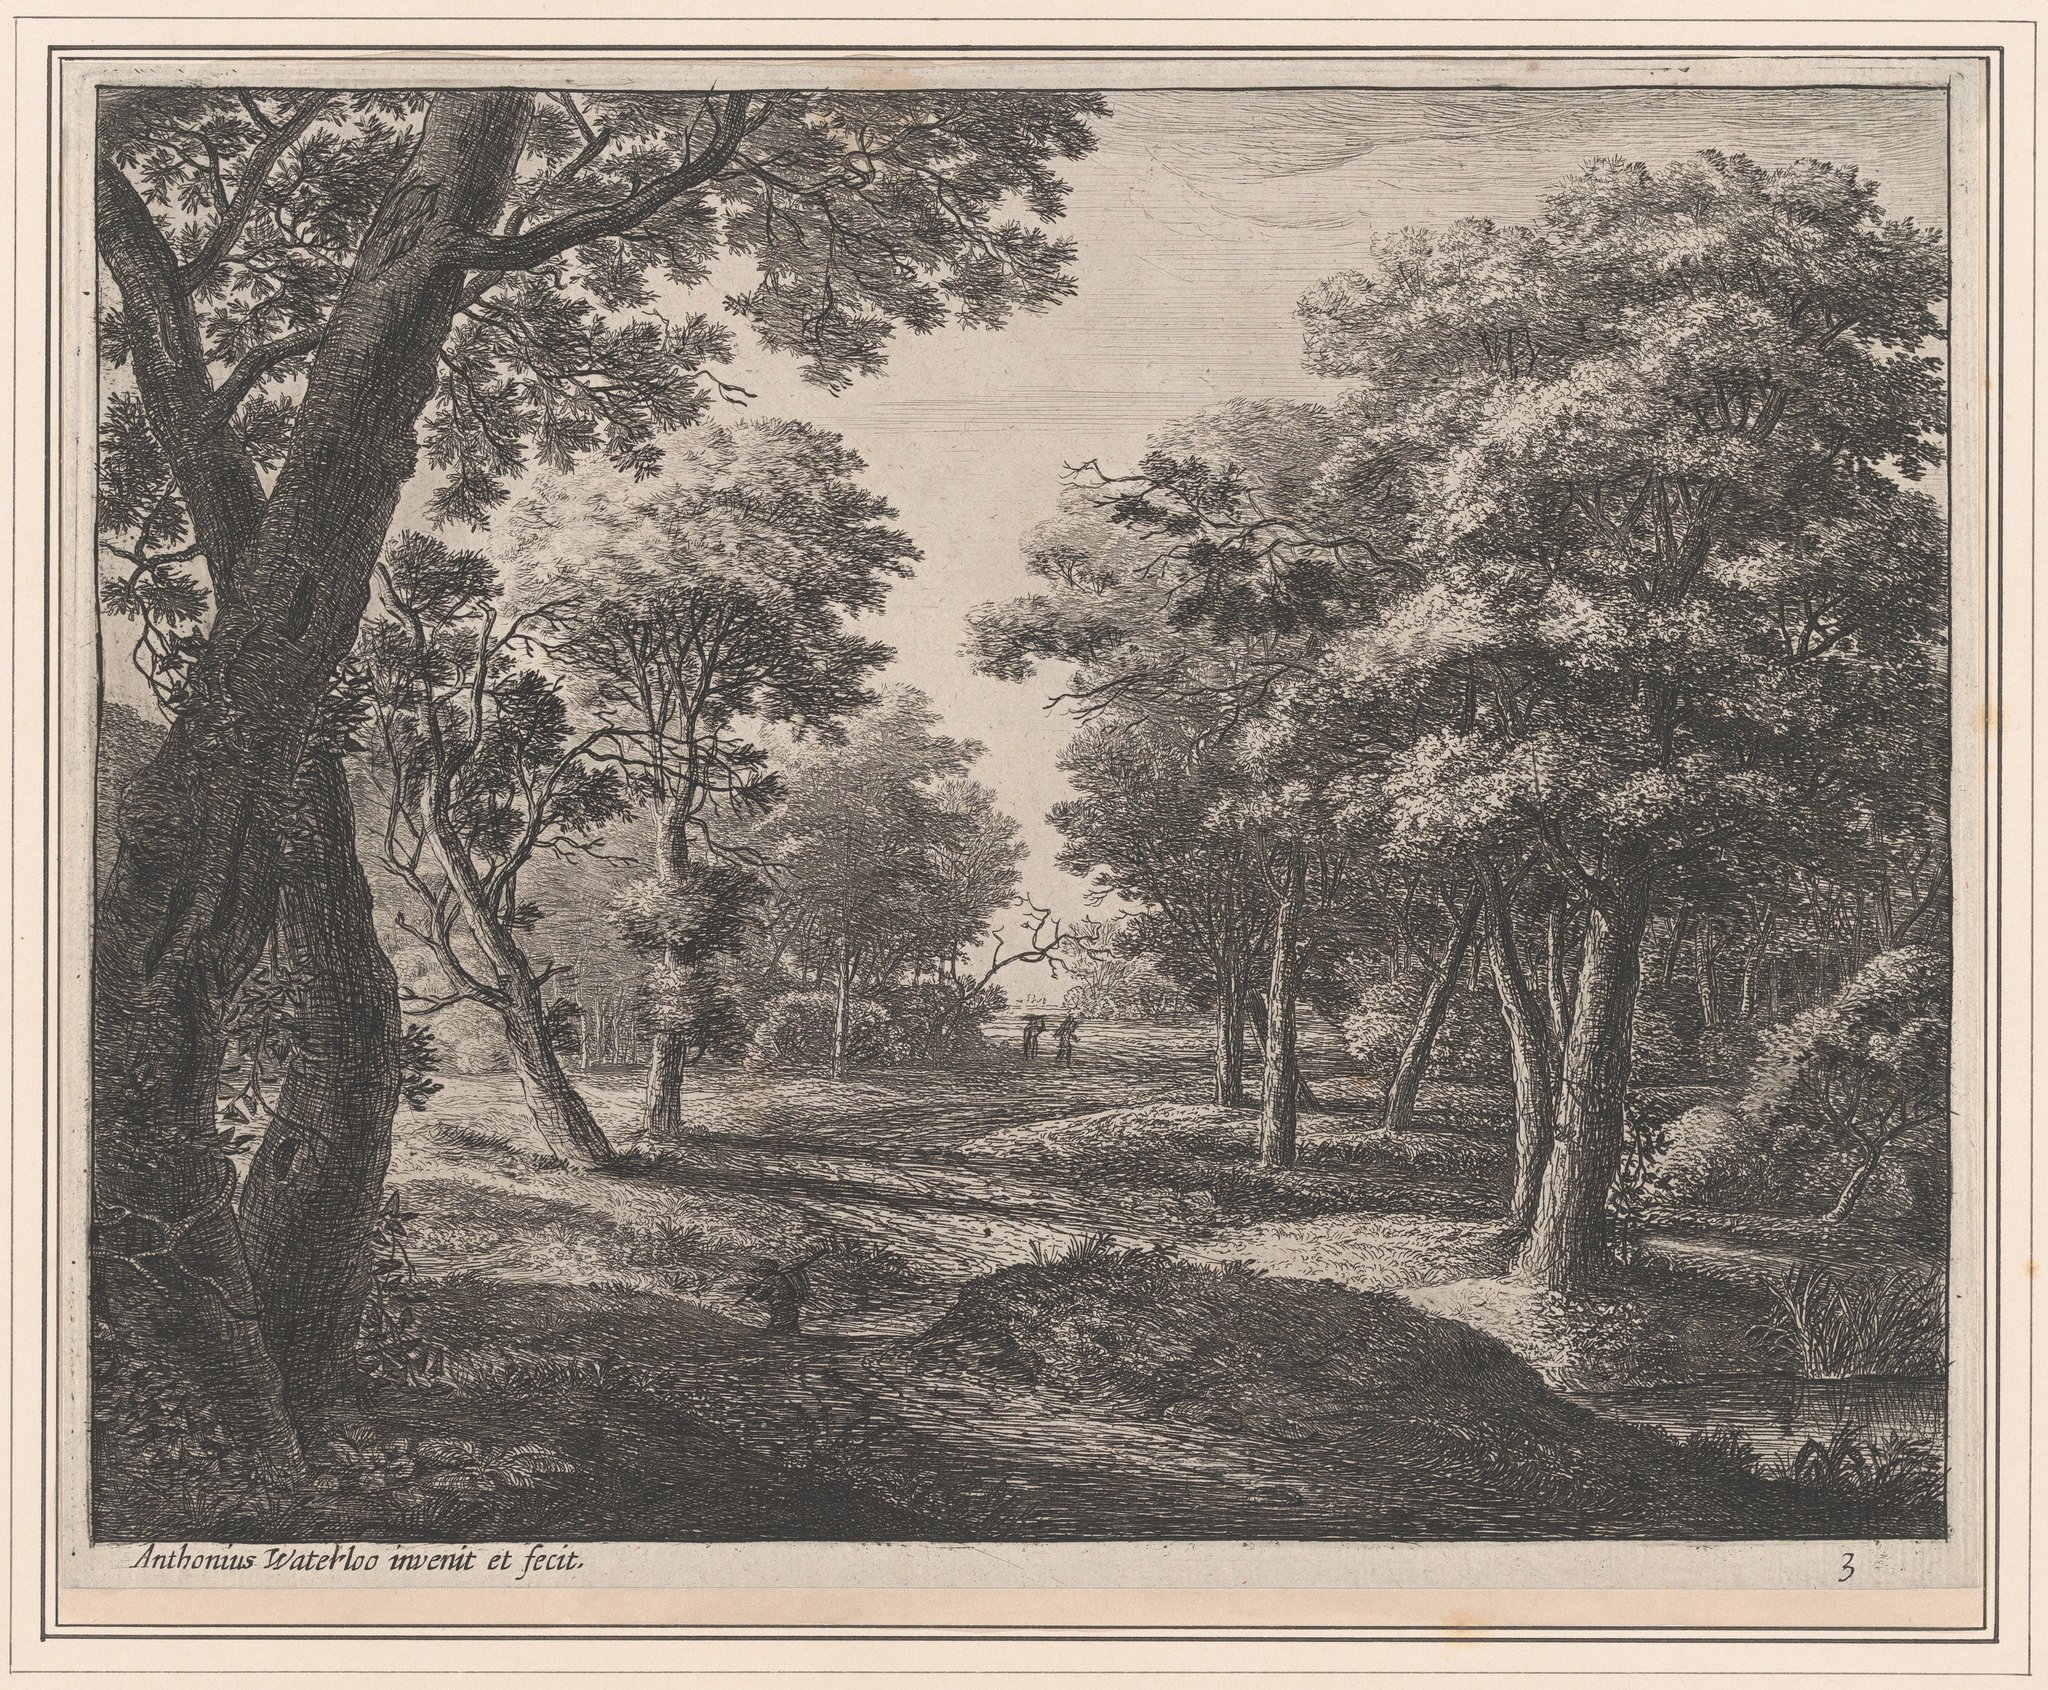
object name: print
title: A Path Through the Woods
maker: anthonie waterloo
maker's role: artist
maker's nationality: dutch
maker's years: 1609-1690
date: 1601-1700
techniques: etching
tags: roads,trees